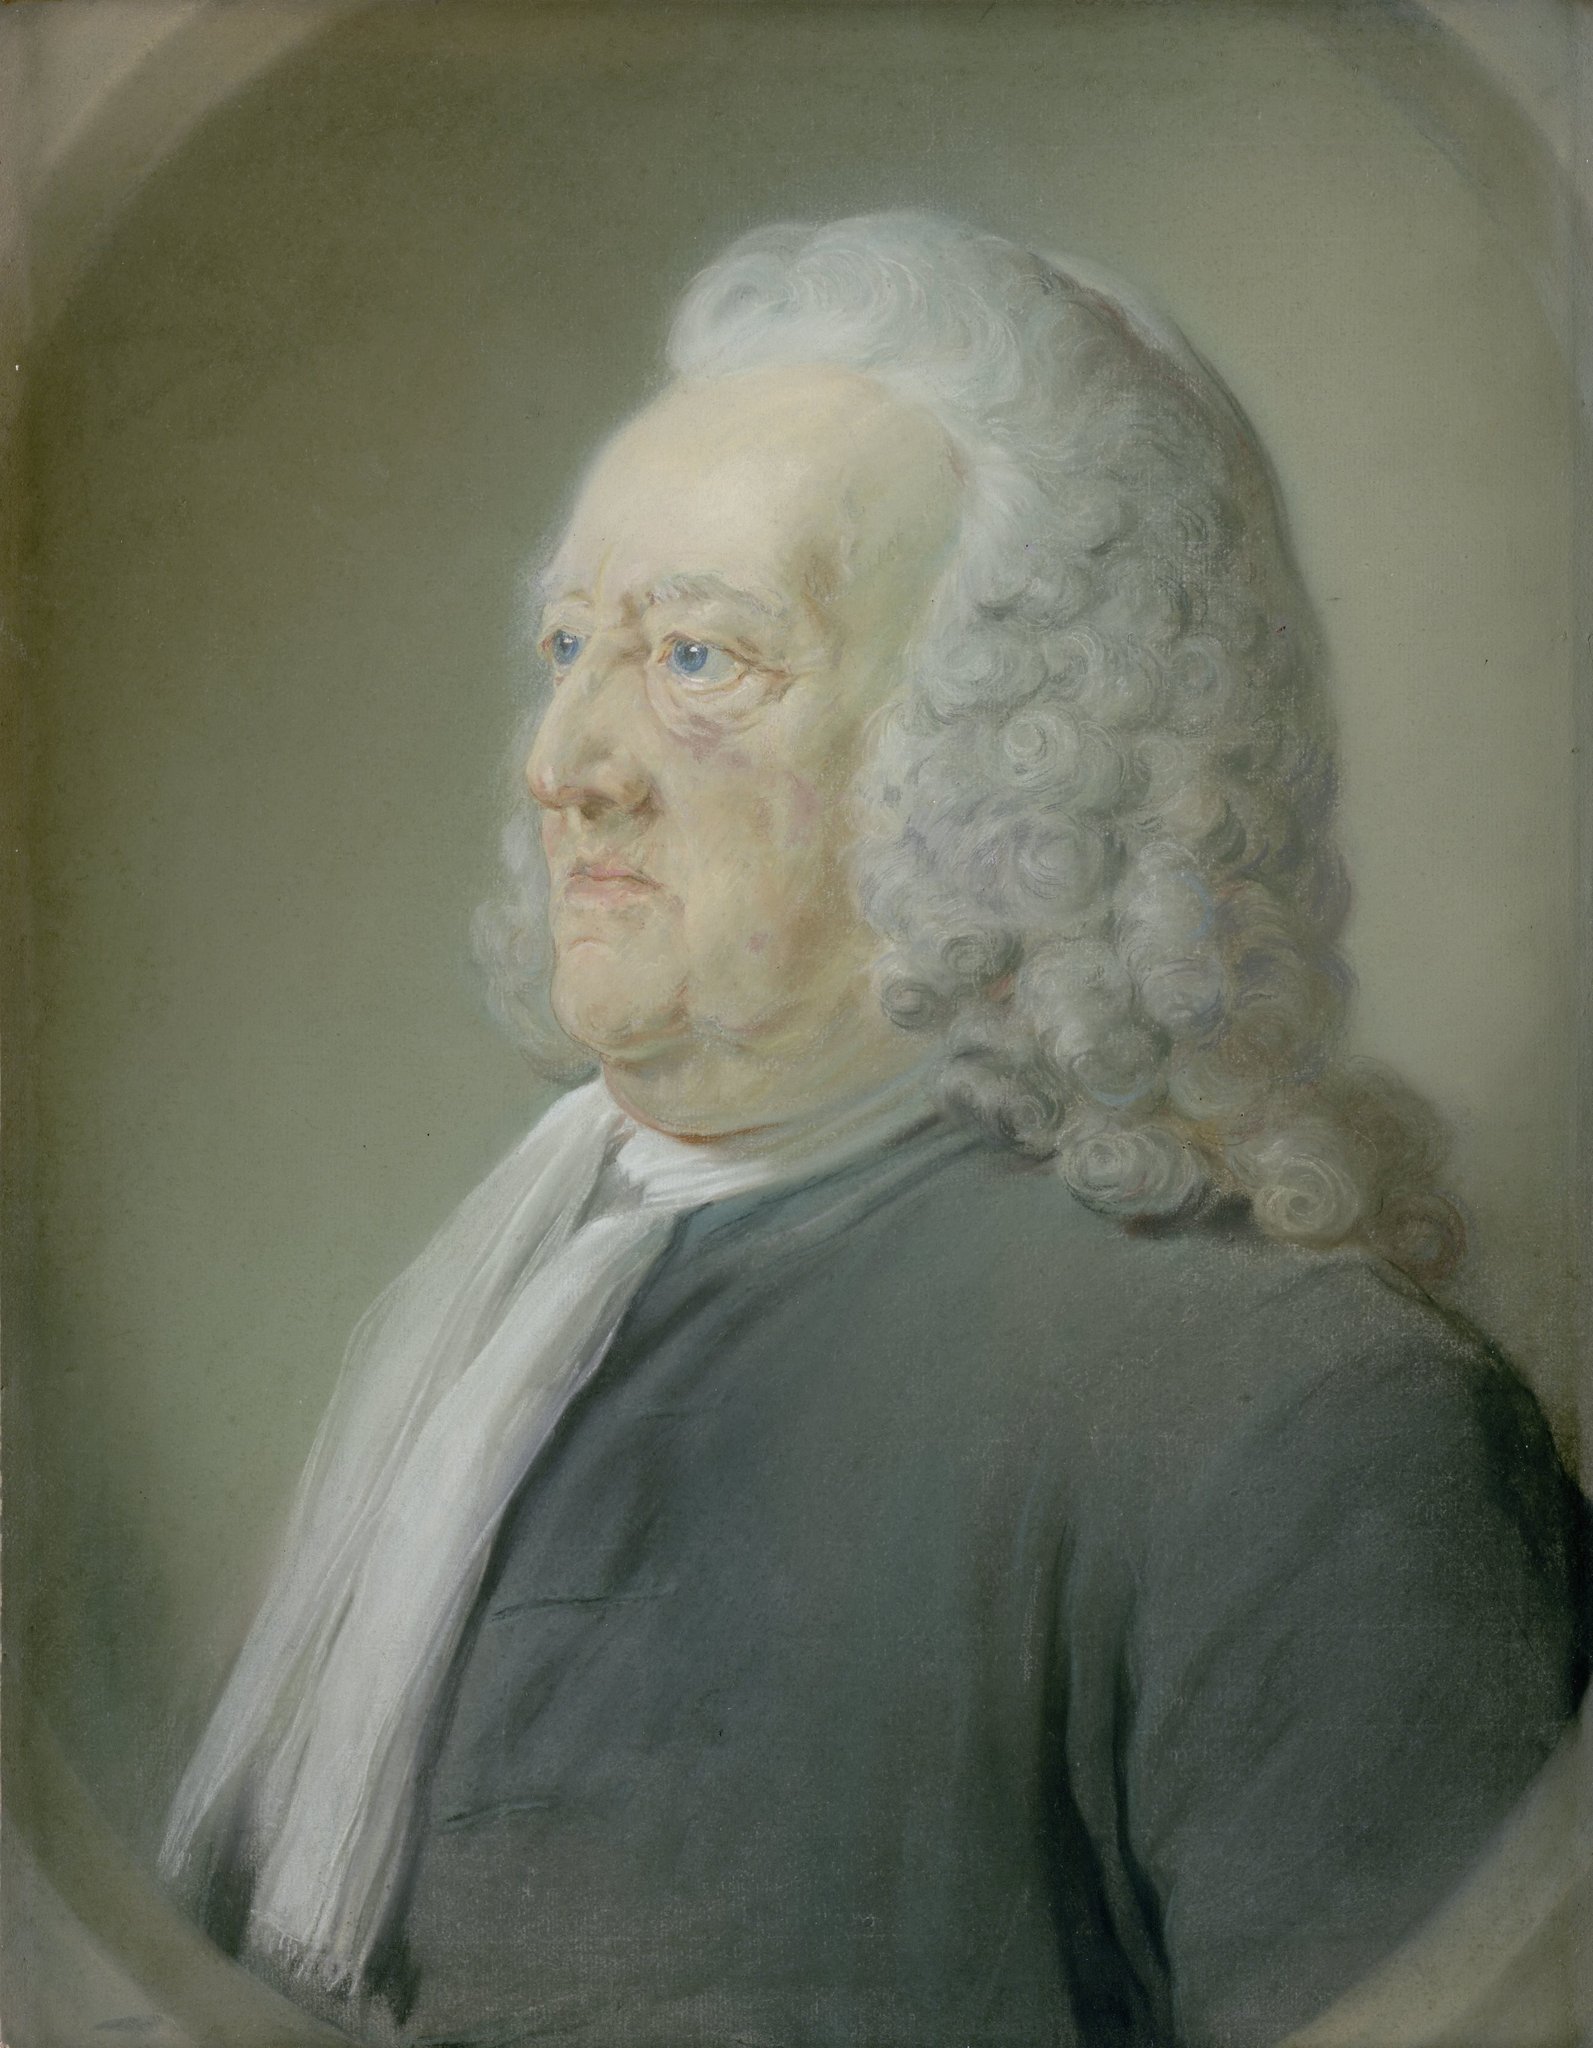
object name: pastel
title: Arent van der Waeyen (1685-1767). Koopman en raad in de vroedschap van Amsterdam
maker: jean baptiste perroneau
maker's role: draughtsman, painter, print maker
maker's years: 1715-1783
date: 1703-1763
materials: canvas, paper, pastel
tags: city council, historical persons, merchant, salesman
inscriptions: label: ‘gecrayonneert door Perronneau Maart 1763’, signature: ‘perronneau’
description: Jean-Baptiste Perronneau (1715 - 1783). Arent van der Waeyen (1685 - 1767), Amsterdam merchant and member of the city council, 1763.